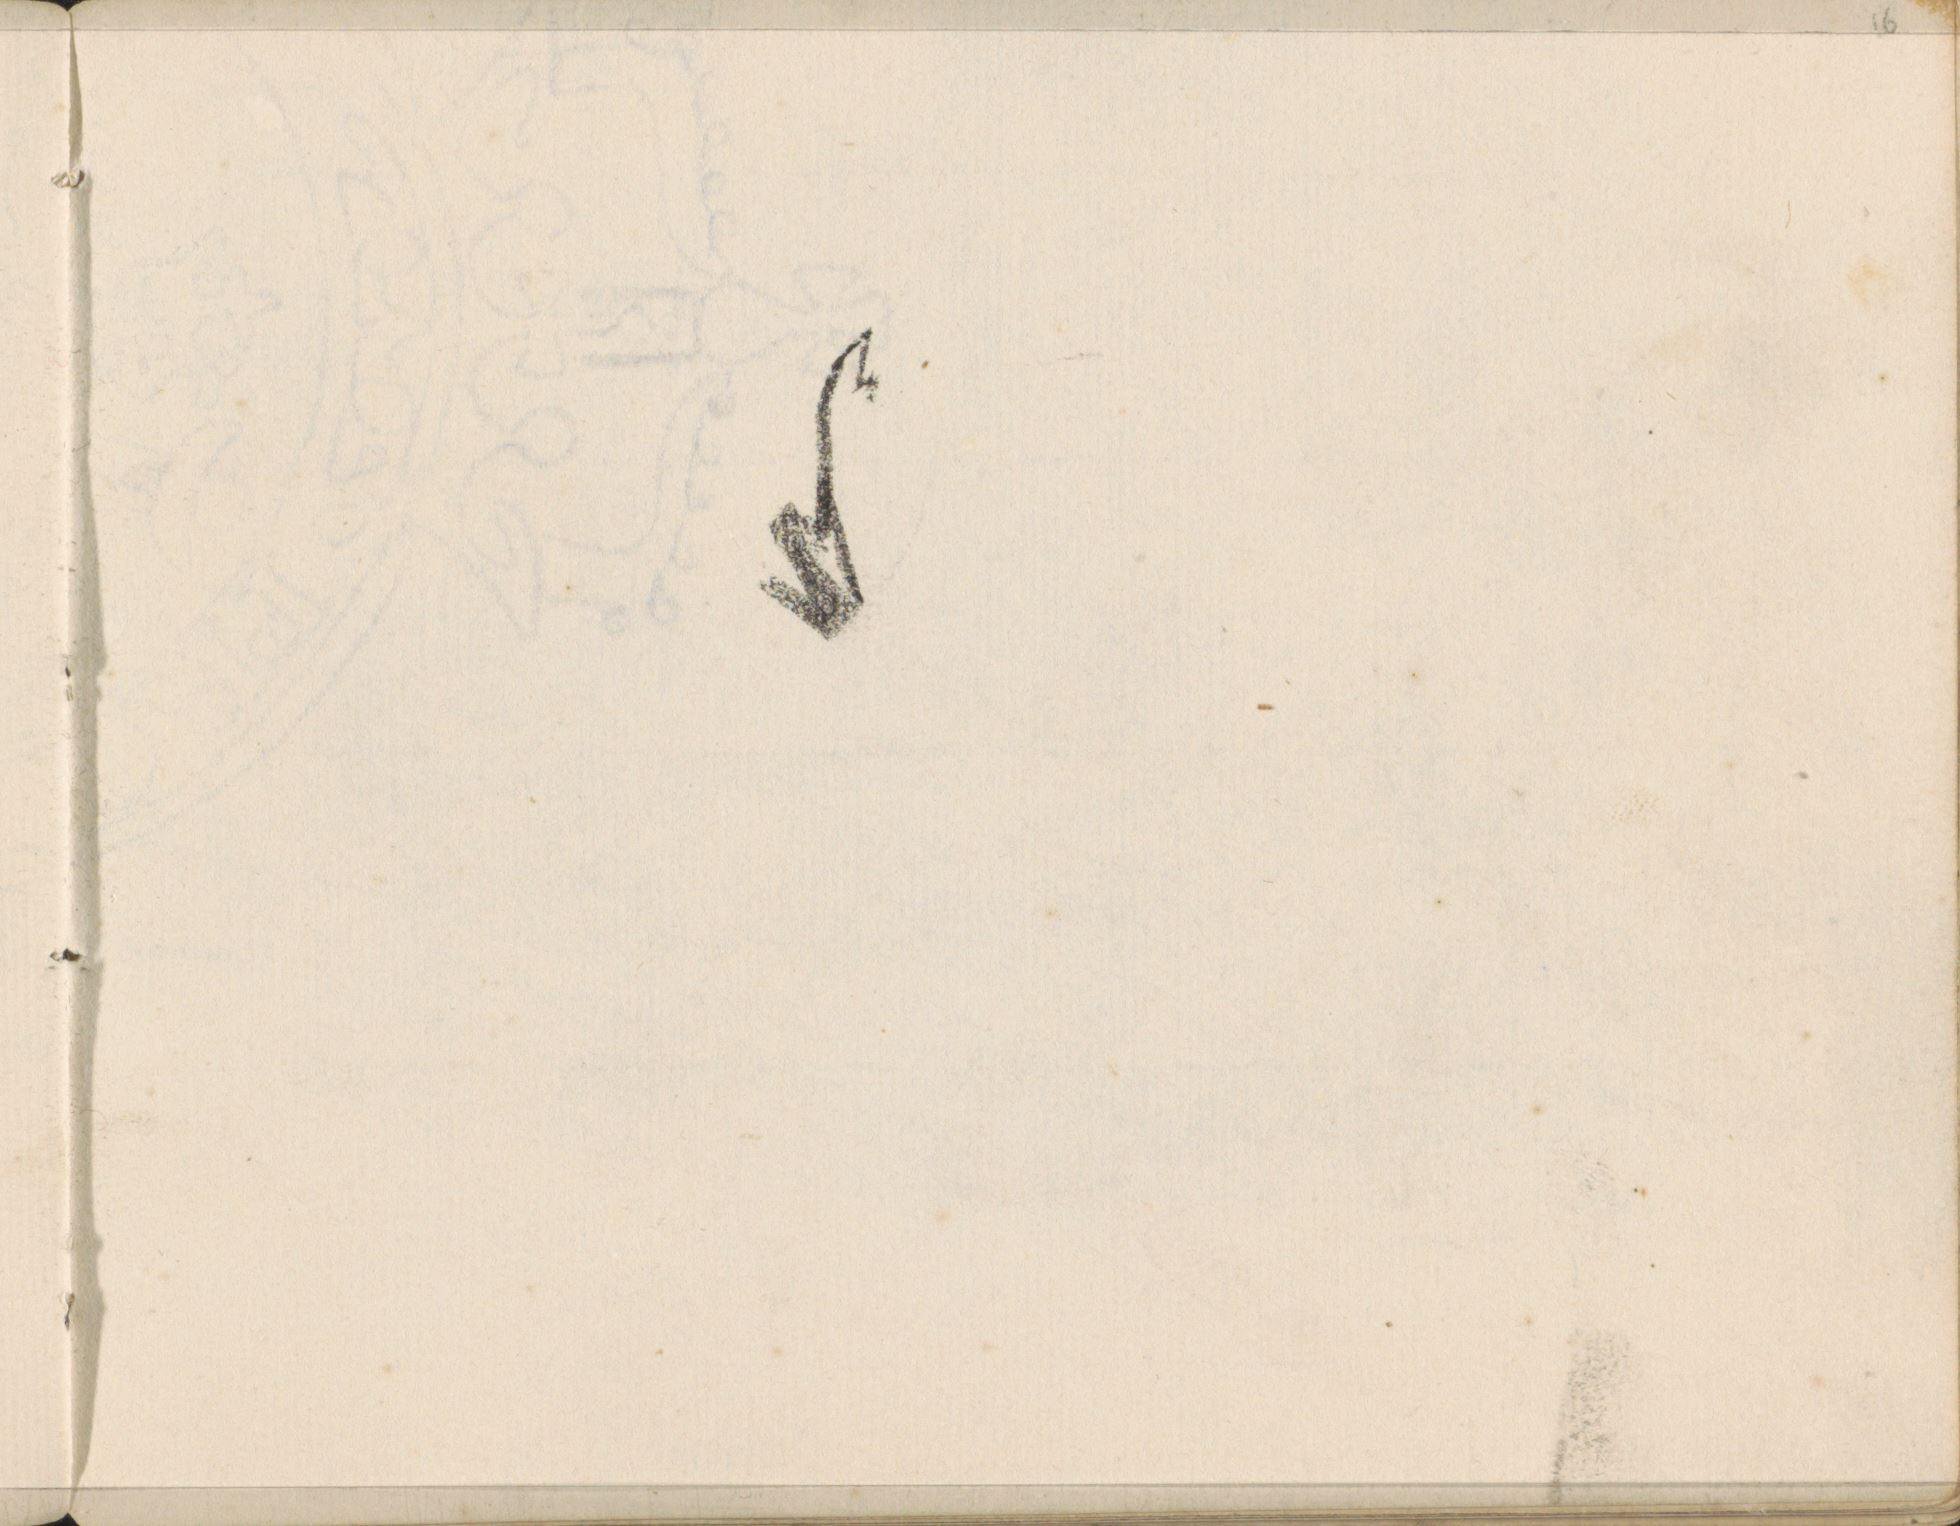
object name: sketchbook leaf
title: Studie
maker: george hendrik breitner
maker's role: draughtsman, painter, print maker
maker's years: 1857-1923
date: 1893-1899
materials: chalk, paper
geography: amsterdam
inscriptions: watermark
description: Pagina 16 uit een schetsboek met 28 bladen.